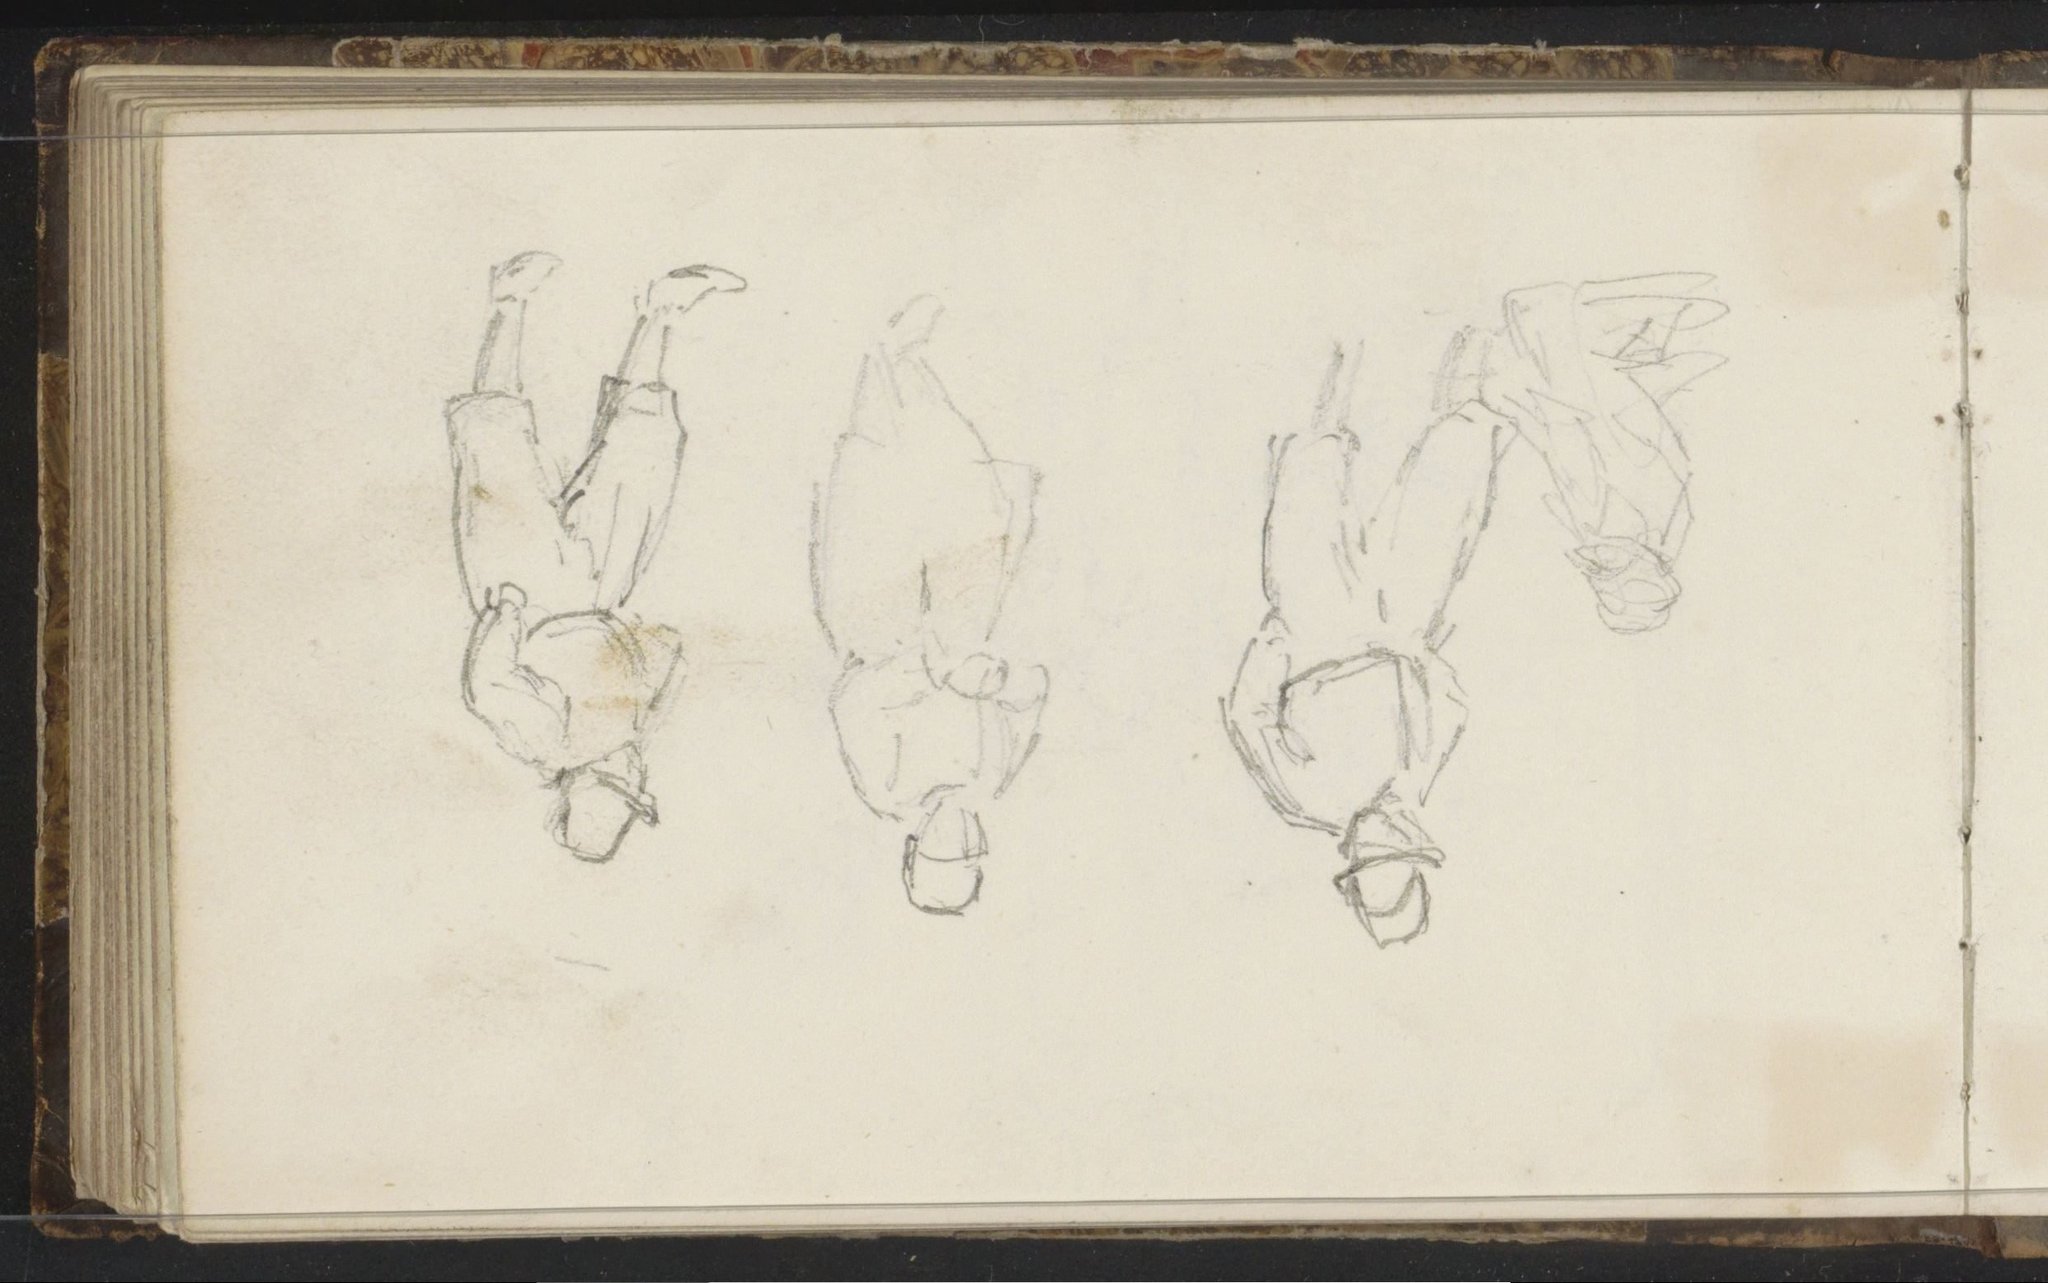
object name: sketchbook leaf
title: Mannen met hoeden en een schoenenpoetser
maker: willem hendrik schmidt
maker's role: draughtsman, painter, print maker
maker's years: 1809-1849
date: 1819-1849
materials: paper, pencil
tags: head-gear: hat (+ men's clothes), handicrafts ~ maintenance and repair (with name of trade or profession)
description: Blad 58 verso uit een schetsboek met 60 bladen.